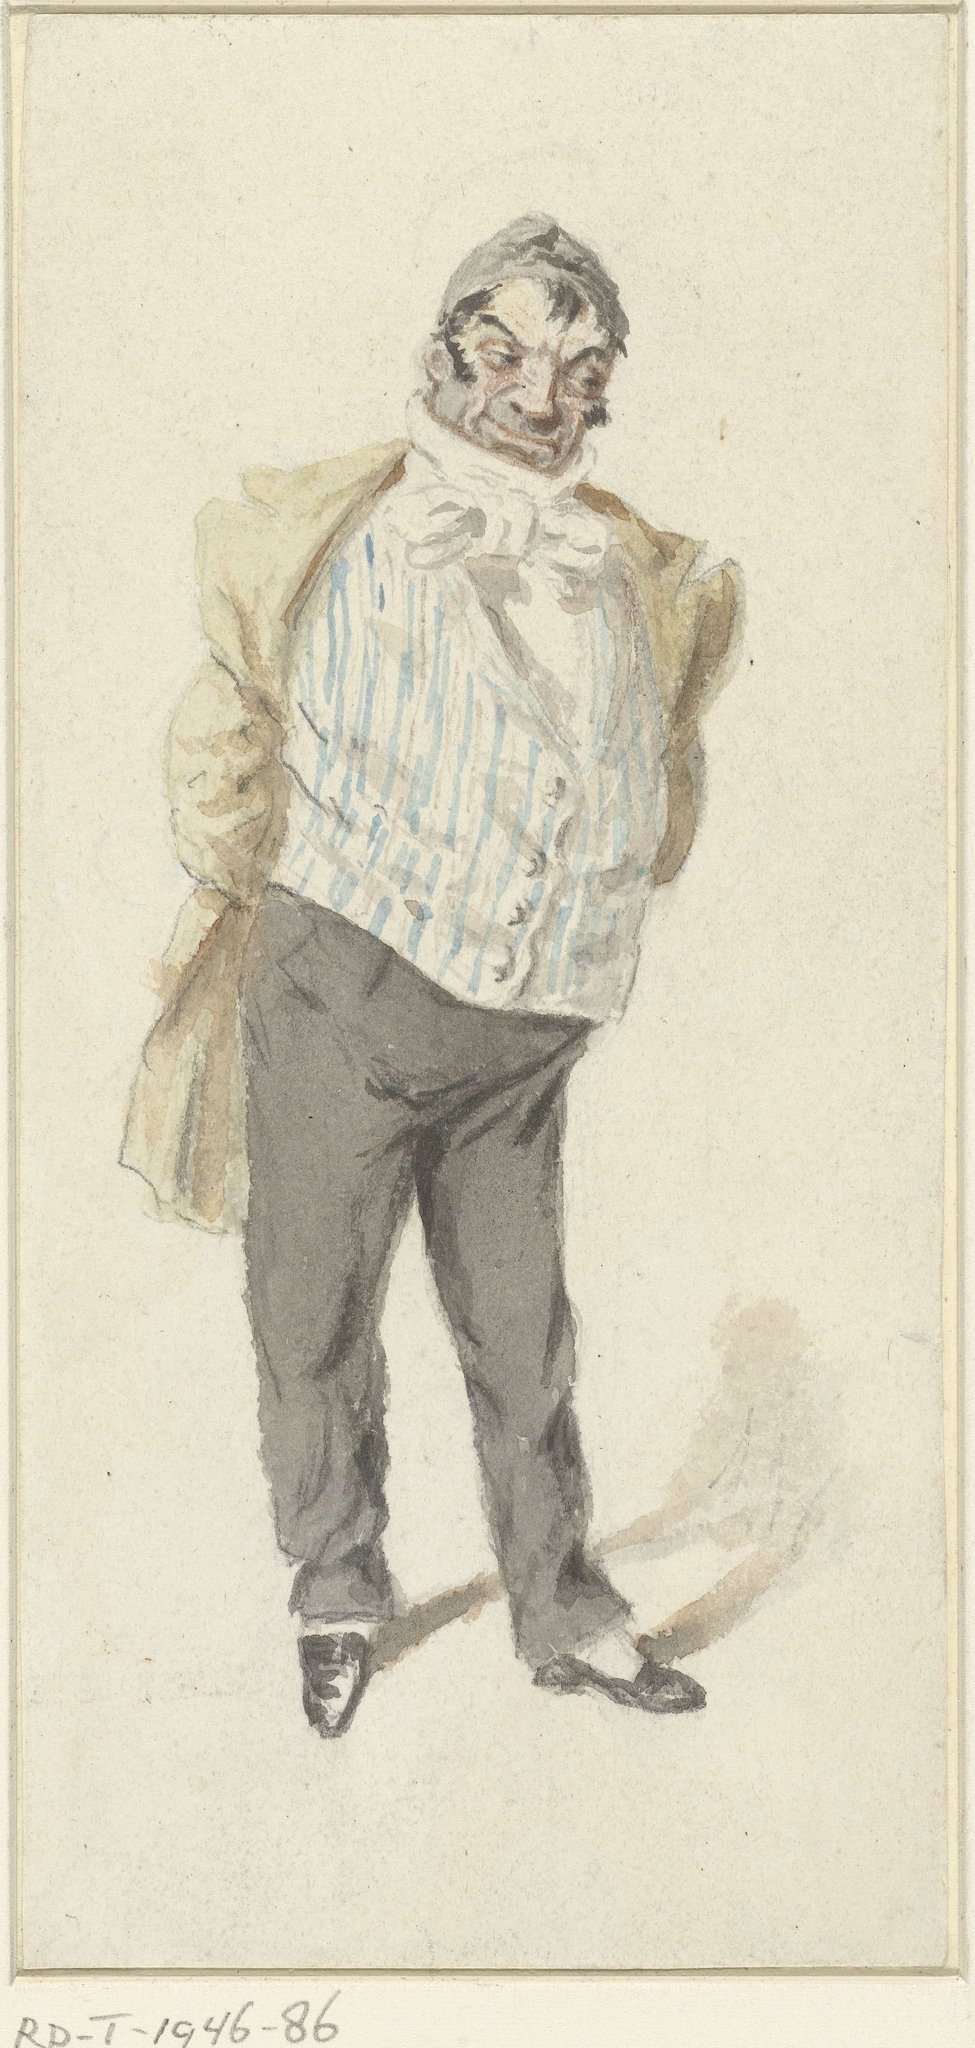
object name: drawing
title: Karikatuur van een staande heer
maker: henry bonaventure monnier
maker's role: draughtsman, print maker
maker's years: 1799-1877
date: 1809-1877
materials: paper, pencil, watercolor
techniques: brush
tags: caricatures (human types)